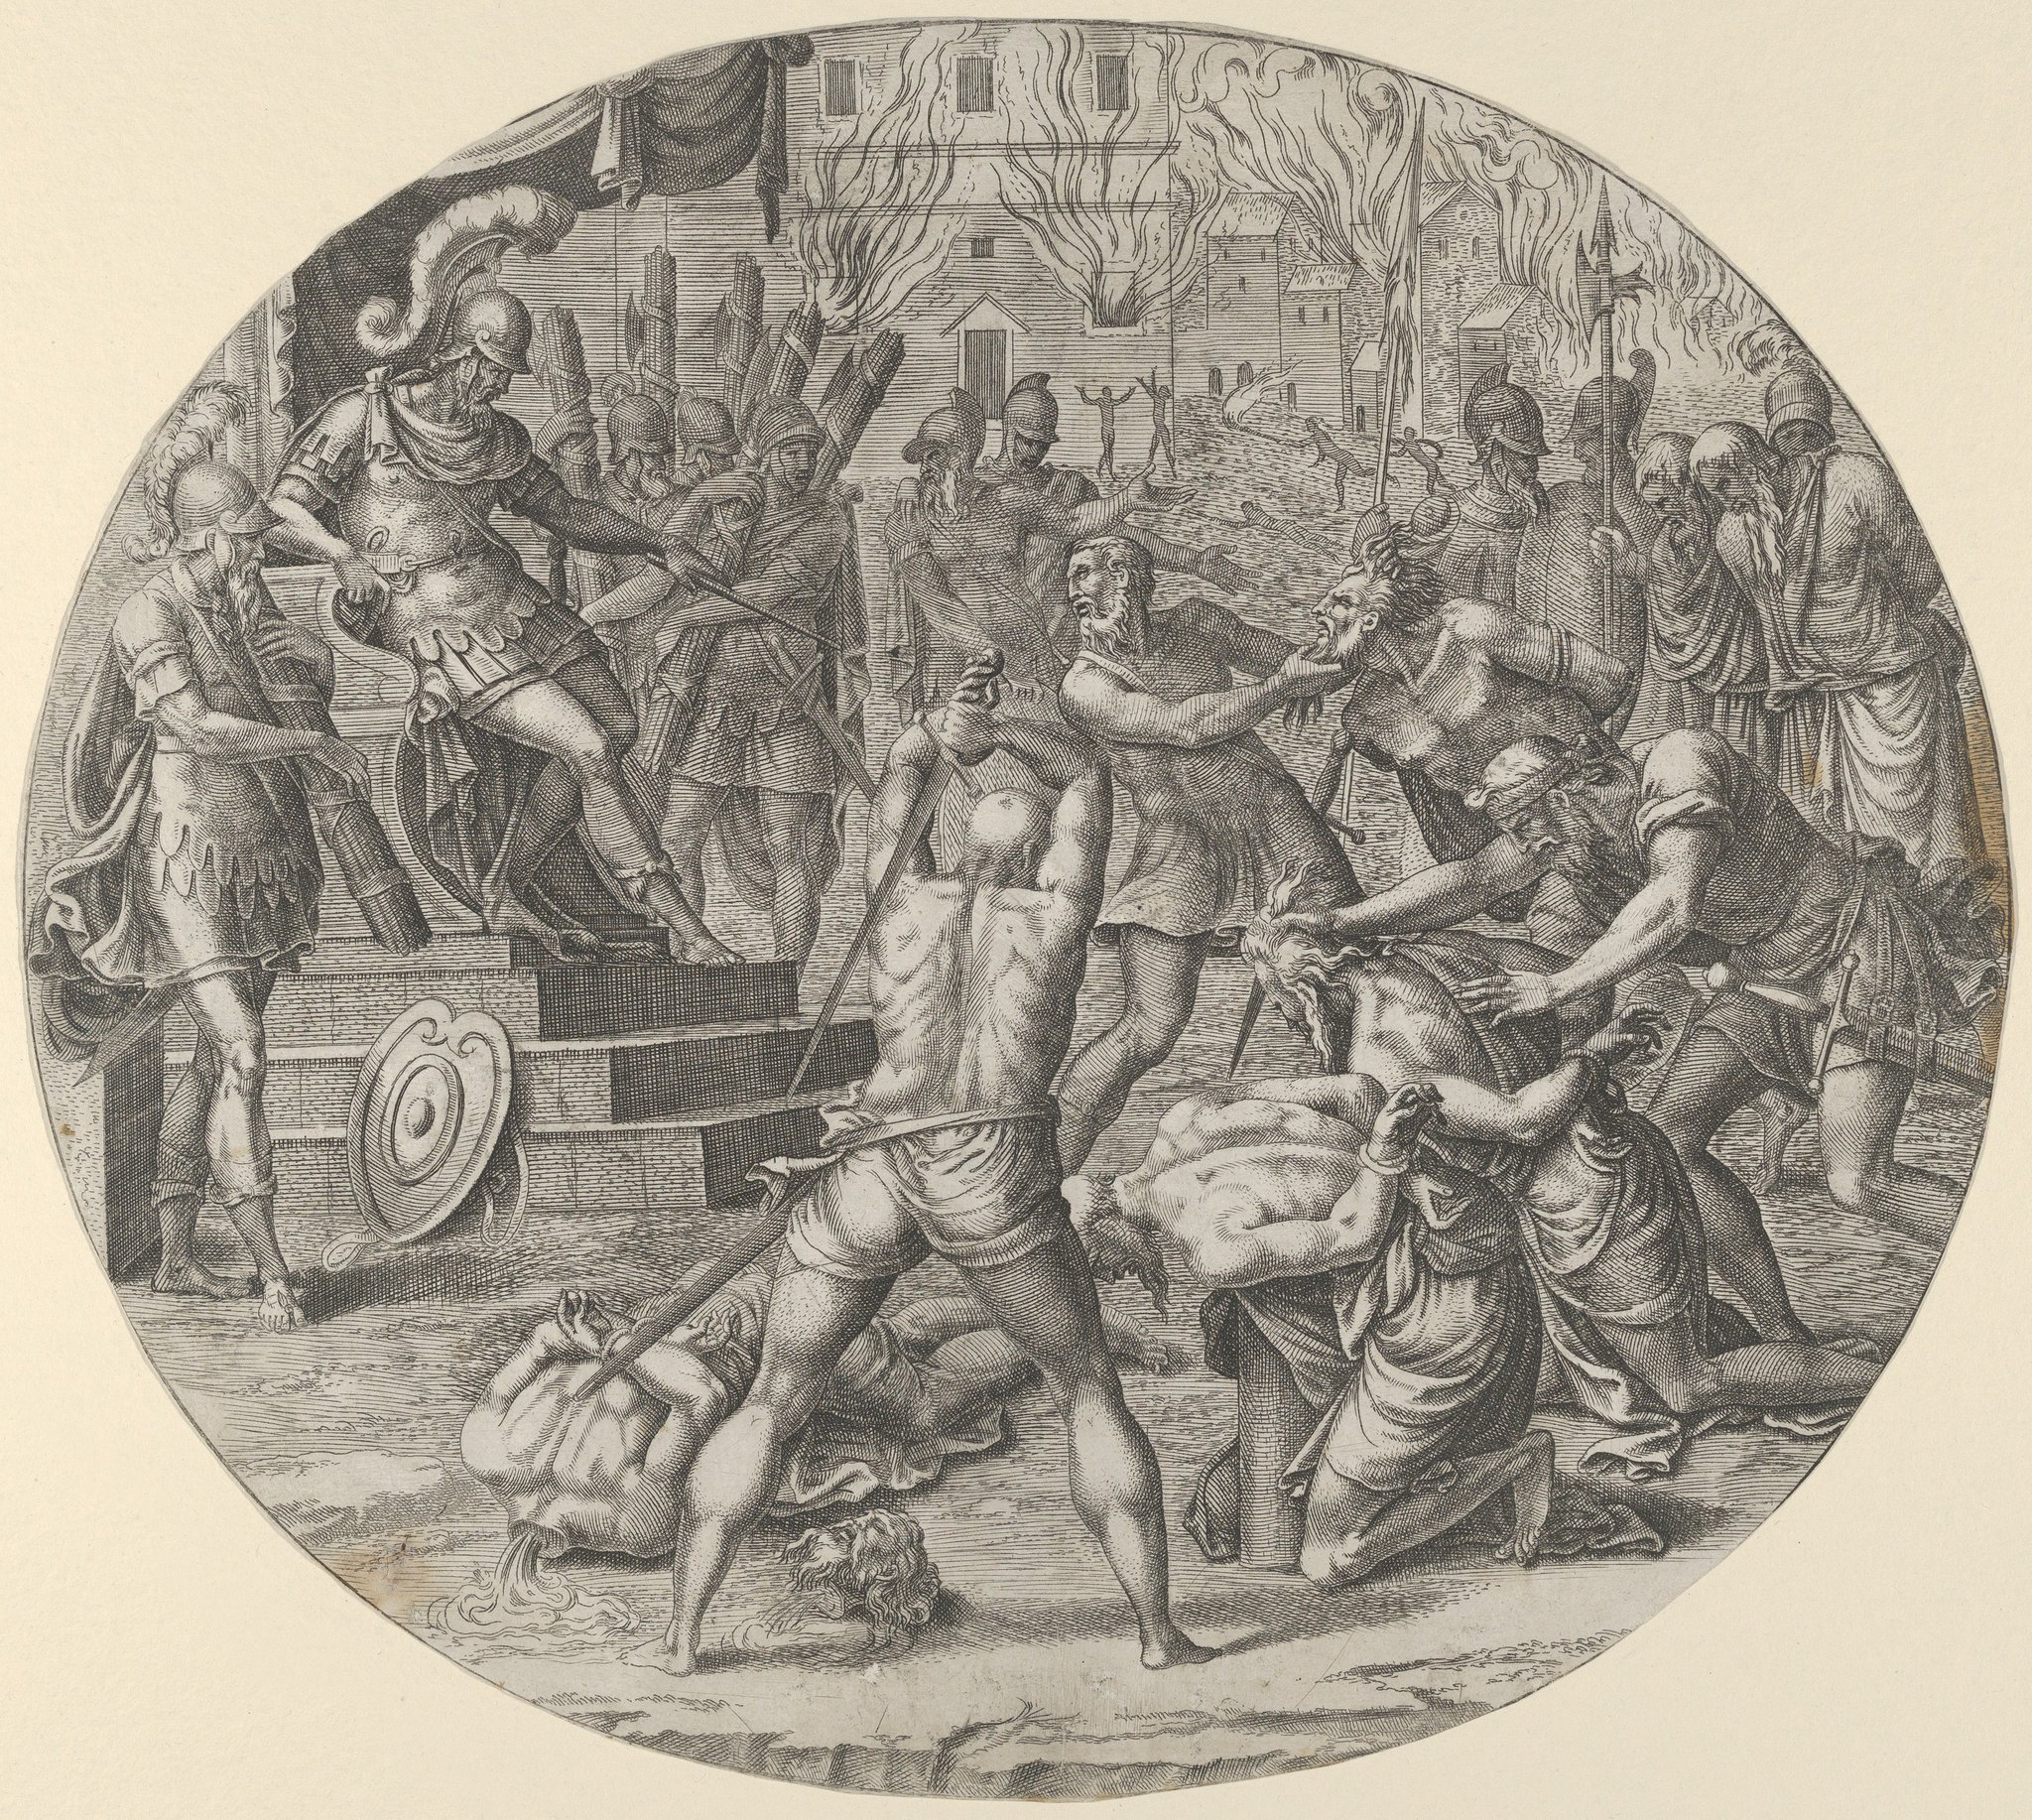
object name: print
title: Wrath, from the 'Seven Deadly Sins'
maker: léon davent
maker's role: artist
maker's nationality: french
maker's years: 1540-1556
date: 1550-1555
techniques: etching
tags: soldiers,swords,anger,men,execution